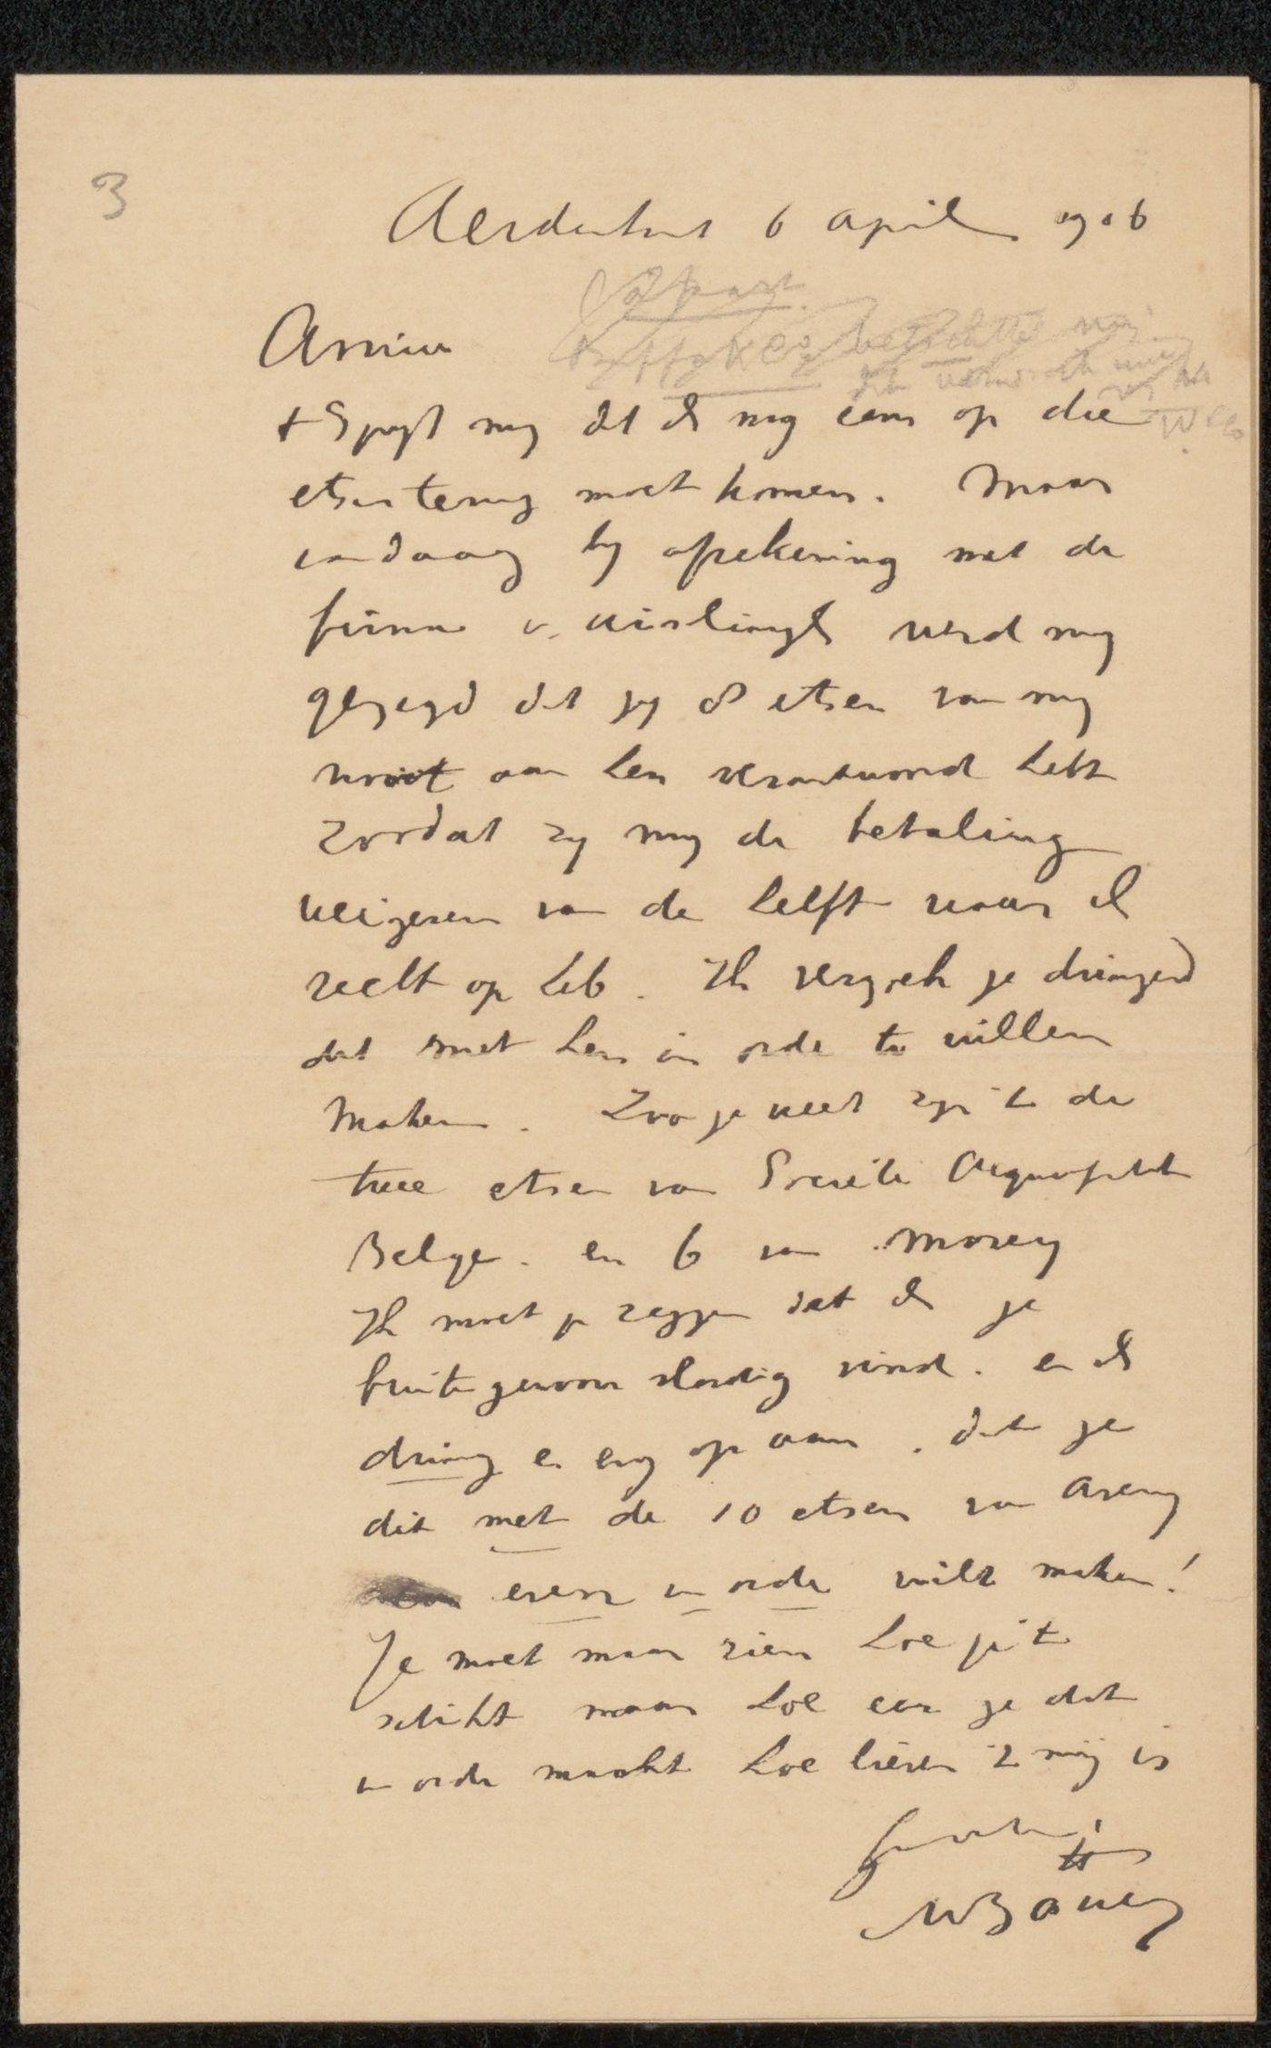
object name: letter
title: Brief aan Philip Zilcken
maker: marius bauer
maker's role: draughtsman, print maker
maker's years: 1867-1932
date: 1906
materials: ink, paper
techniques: pen, writing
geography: aerdenhout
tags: new york (city), samuel putnam avery, the hague, painter, draughtsman, philip zilcken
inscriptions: collector's mark: ‘RPK’